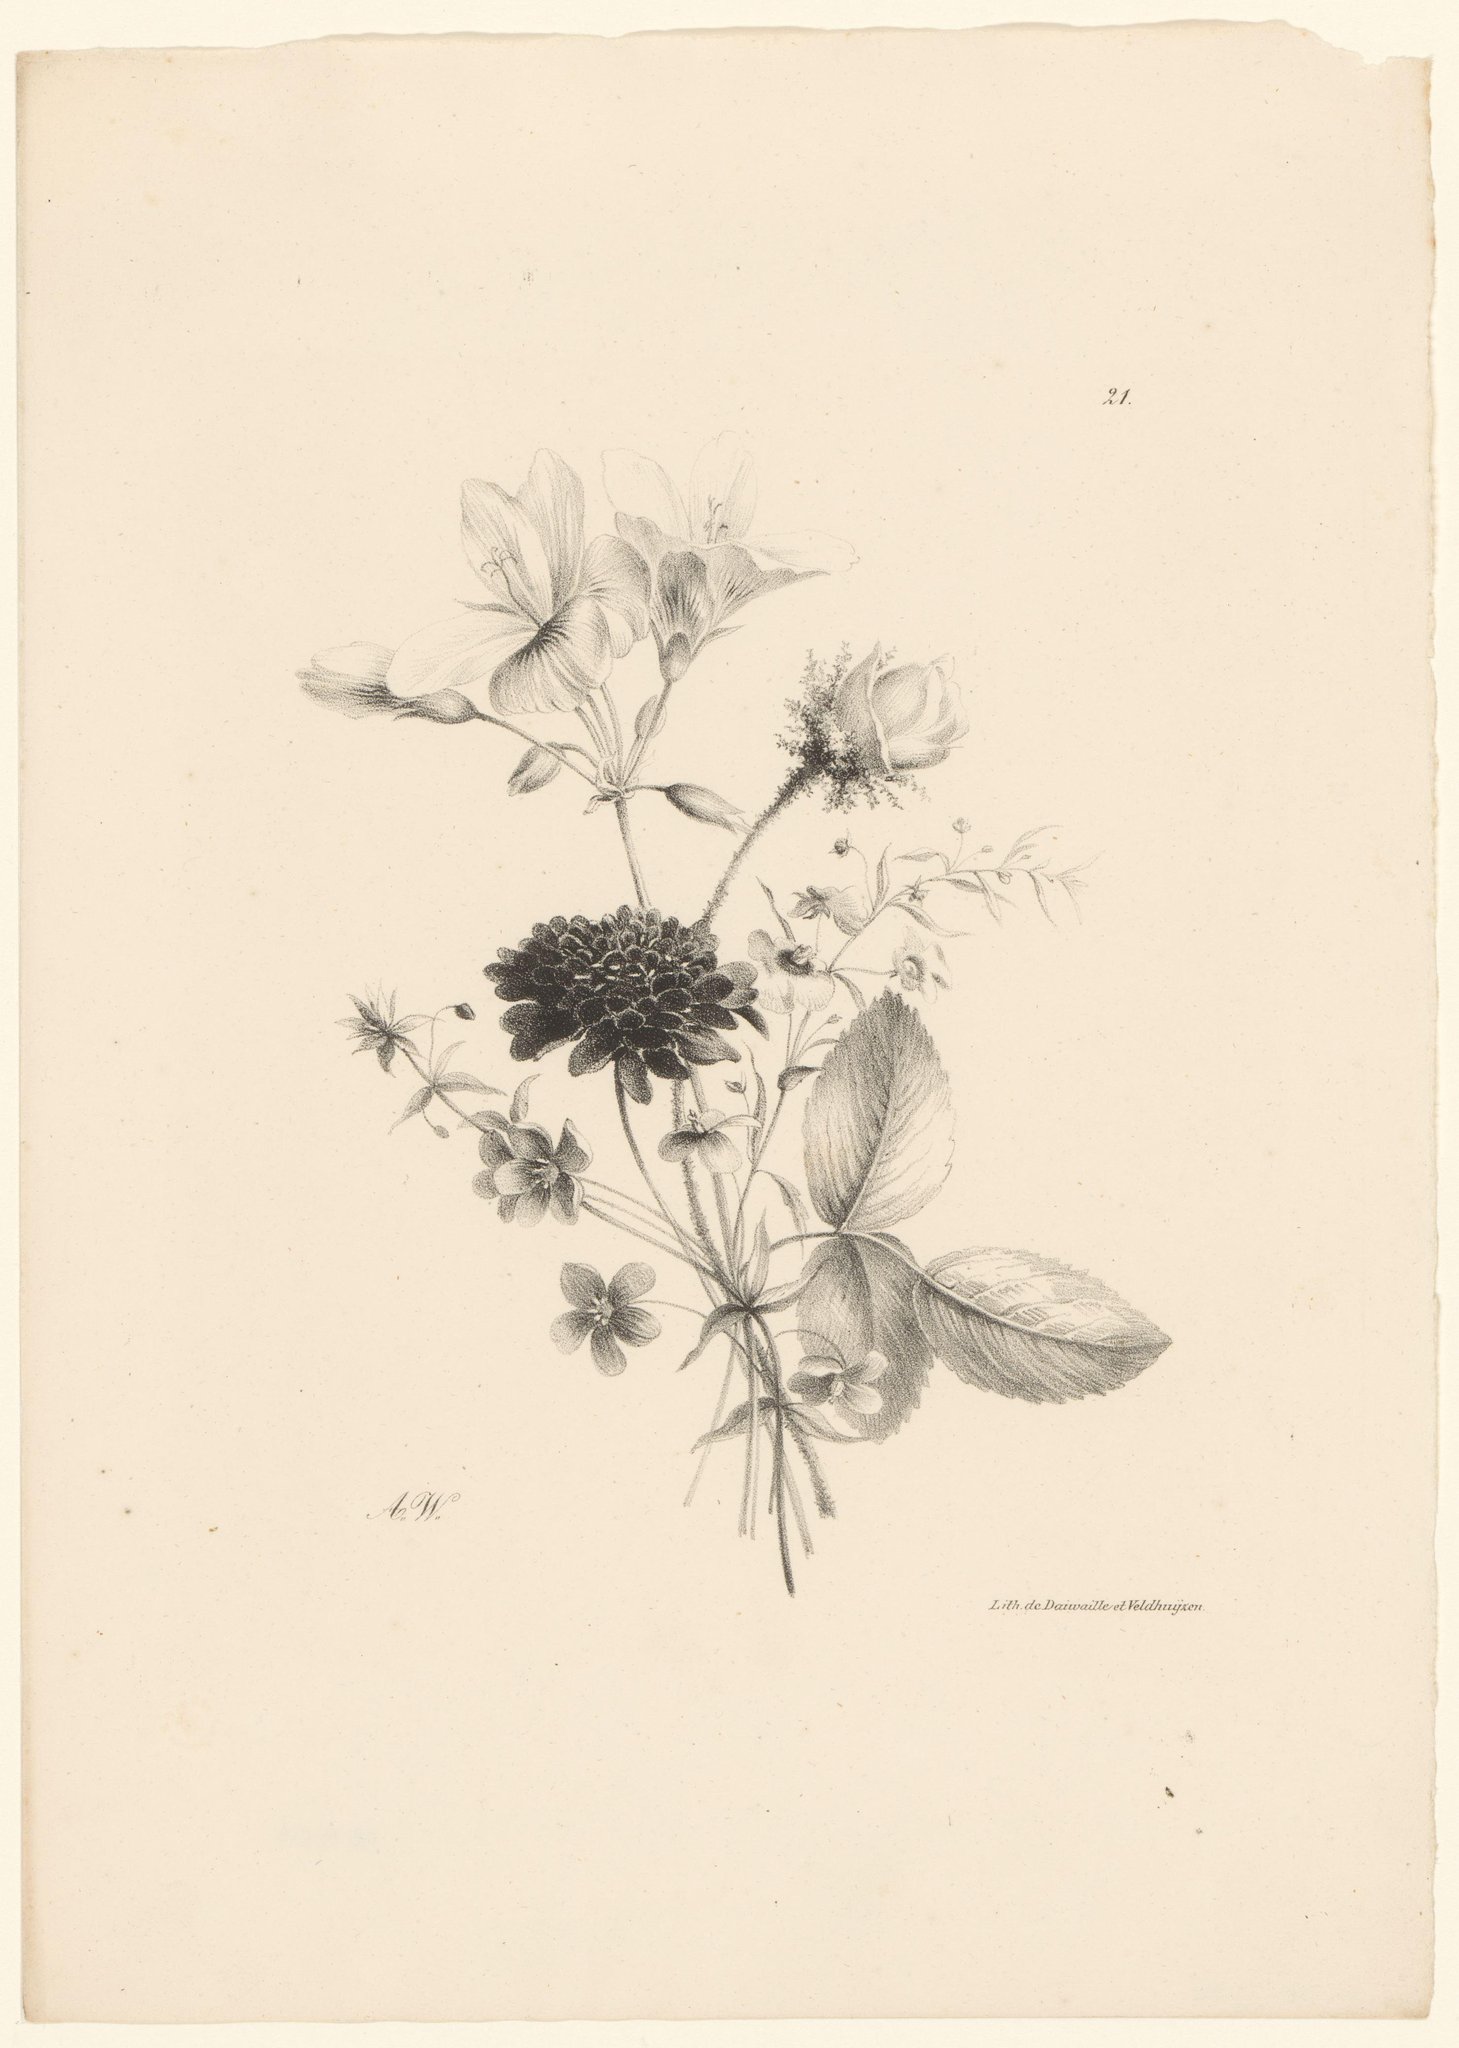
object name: print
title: Bloemen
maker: anton weiss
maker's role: draughtsman, print maker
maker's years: 1801-1851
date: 1831-1832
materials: paper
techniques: lithograph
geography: amsterdam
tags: flowers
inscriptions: watermark